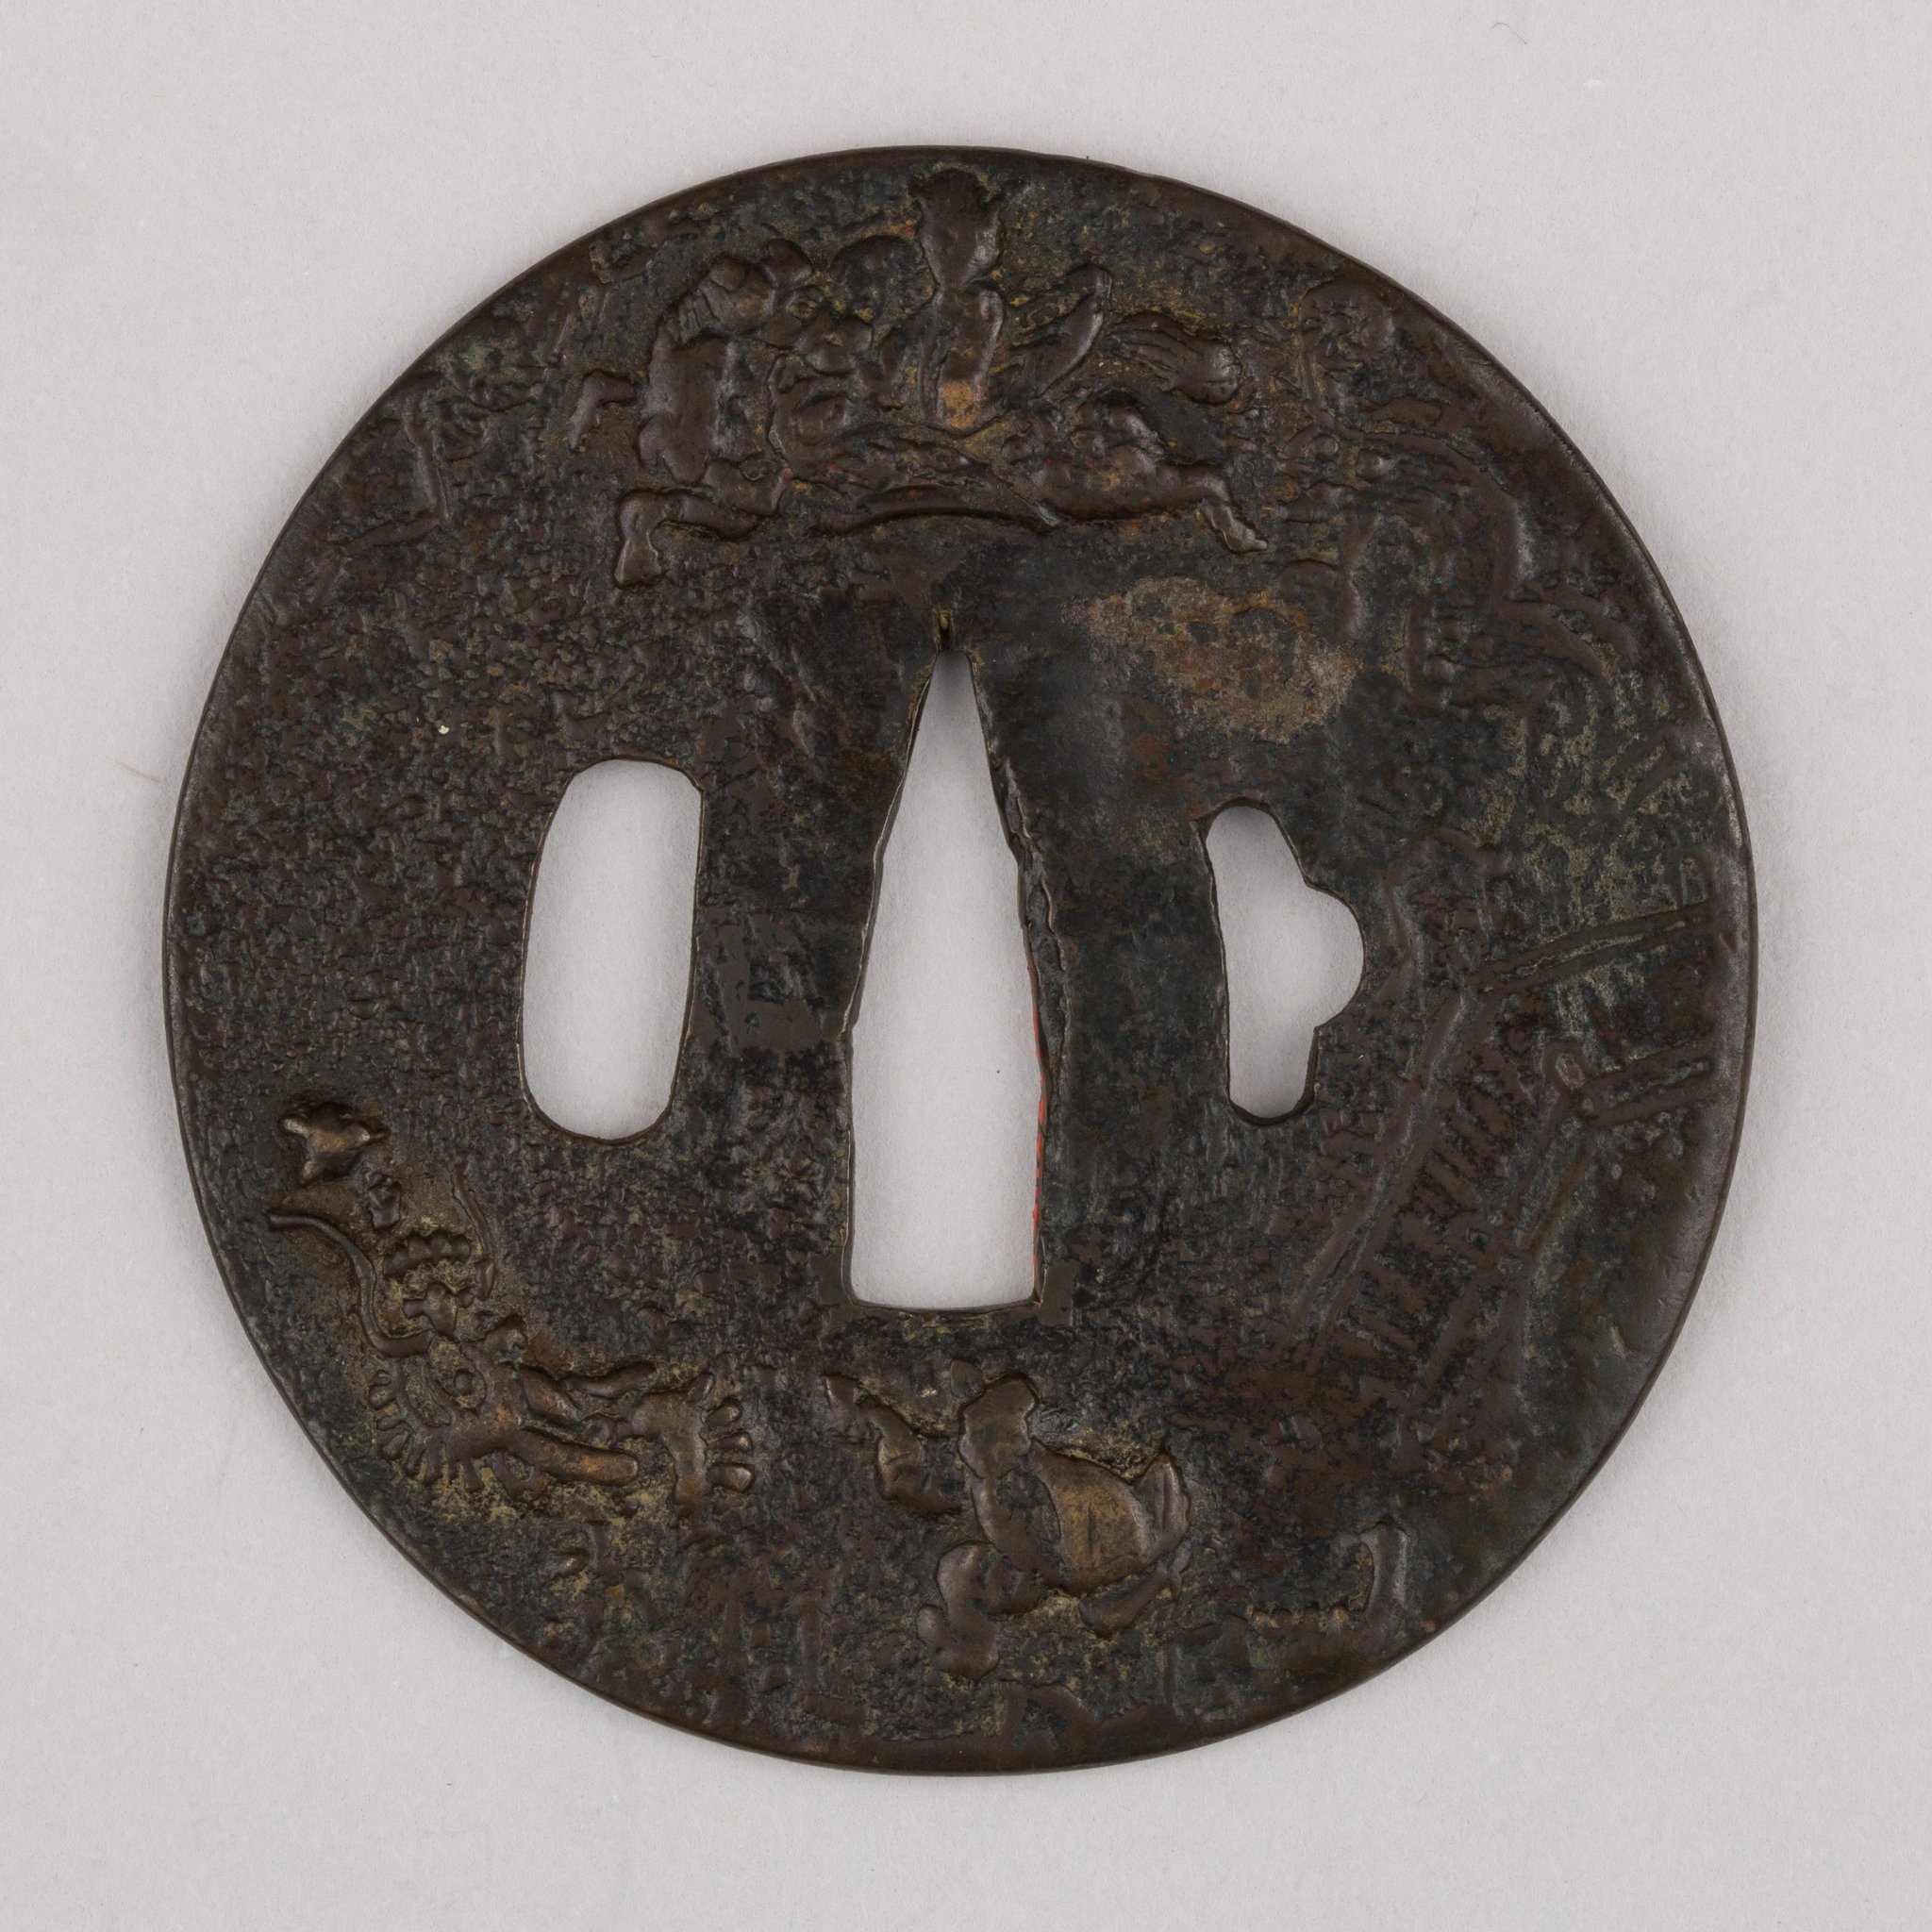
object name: sword guard tsuba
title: Sword Guard (Tsuba)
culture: japanese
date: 1501-1600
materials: copper, copper alloy, iron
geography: japan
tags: dragons,horses